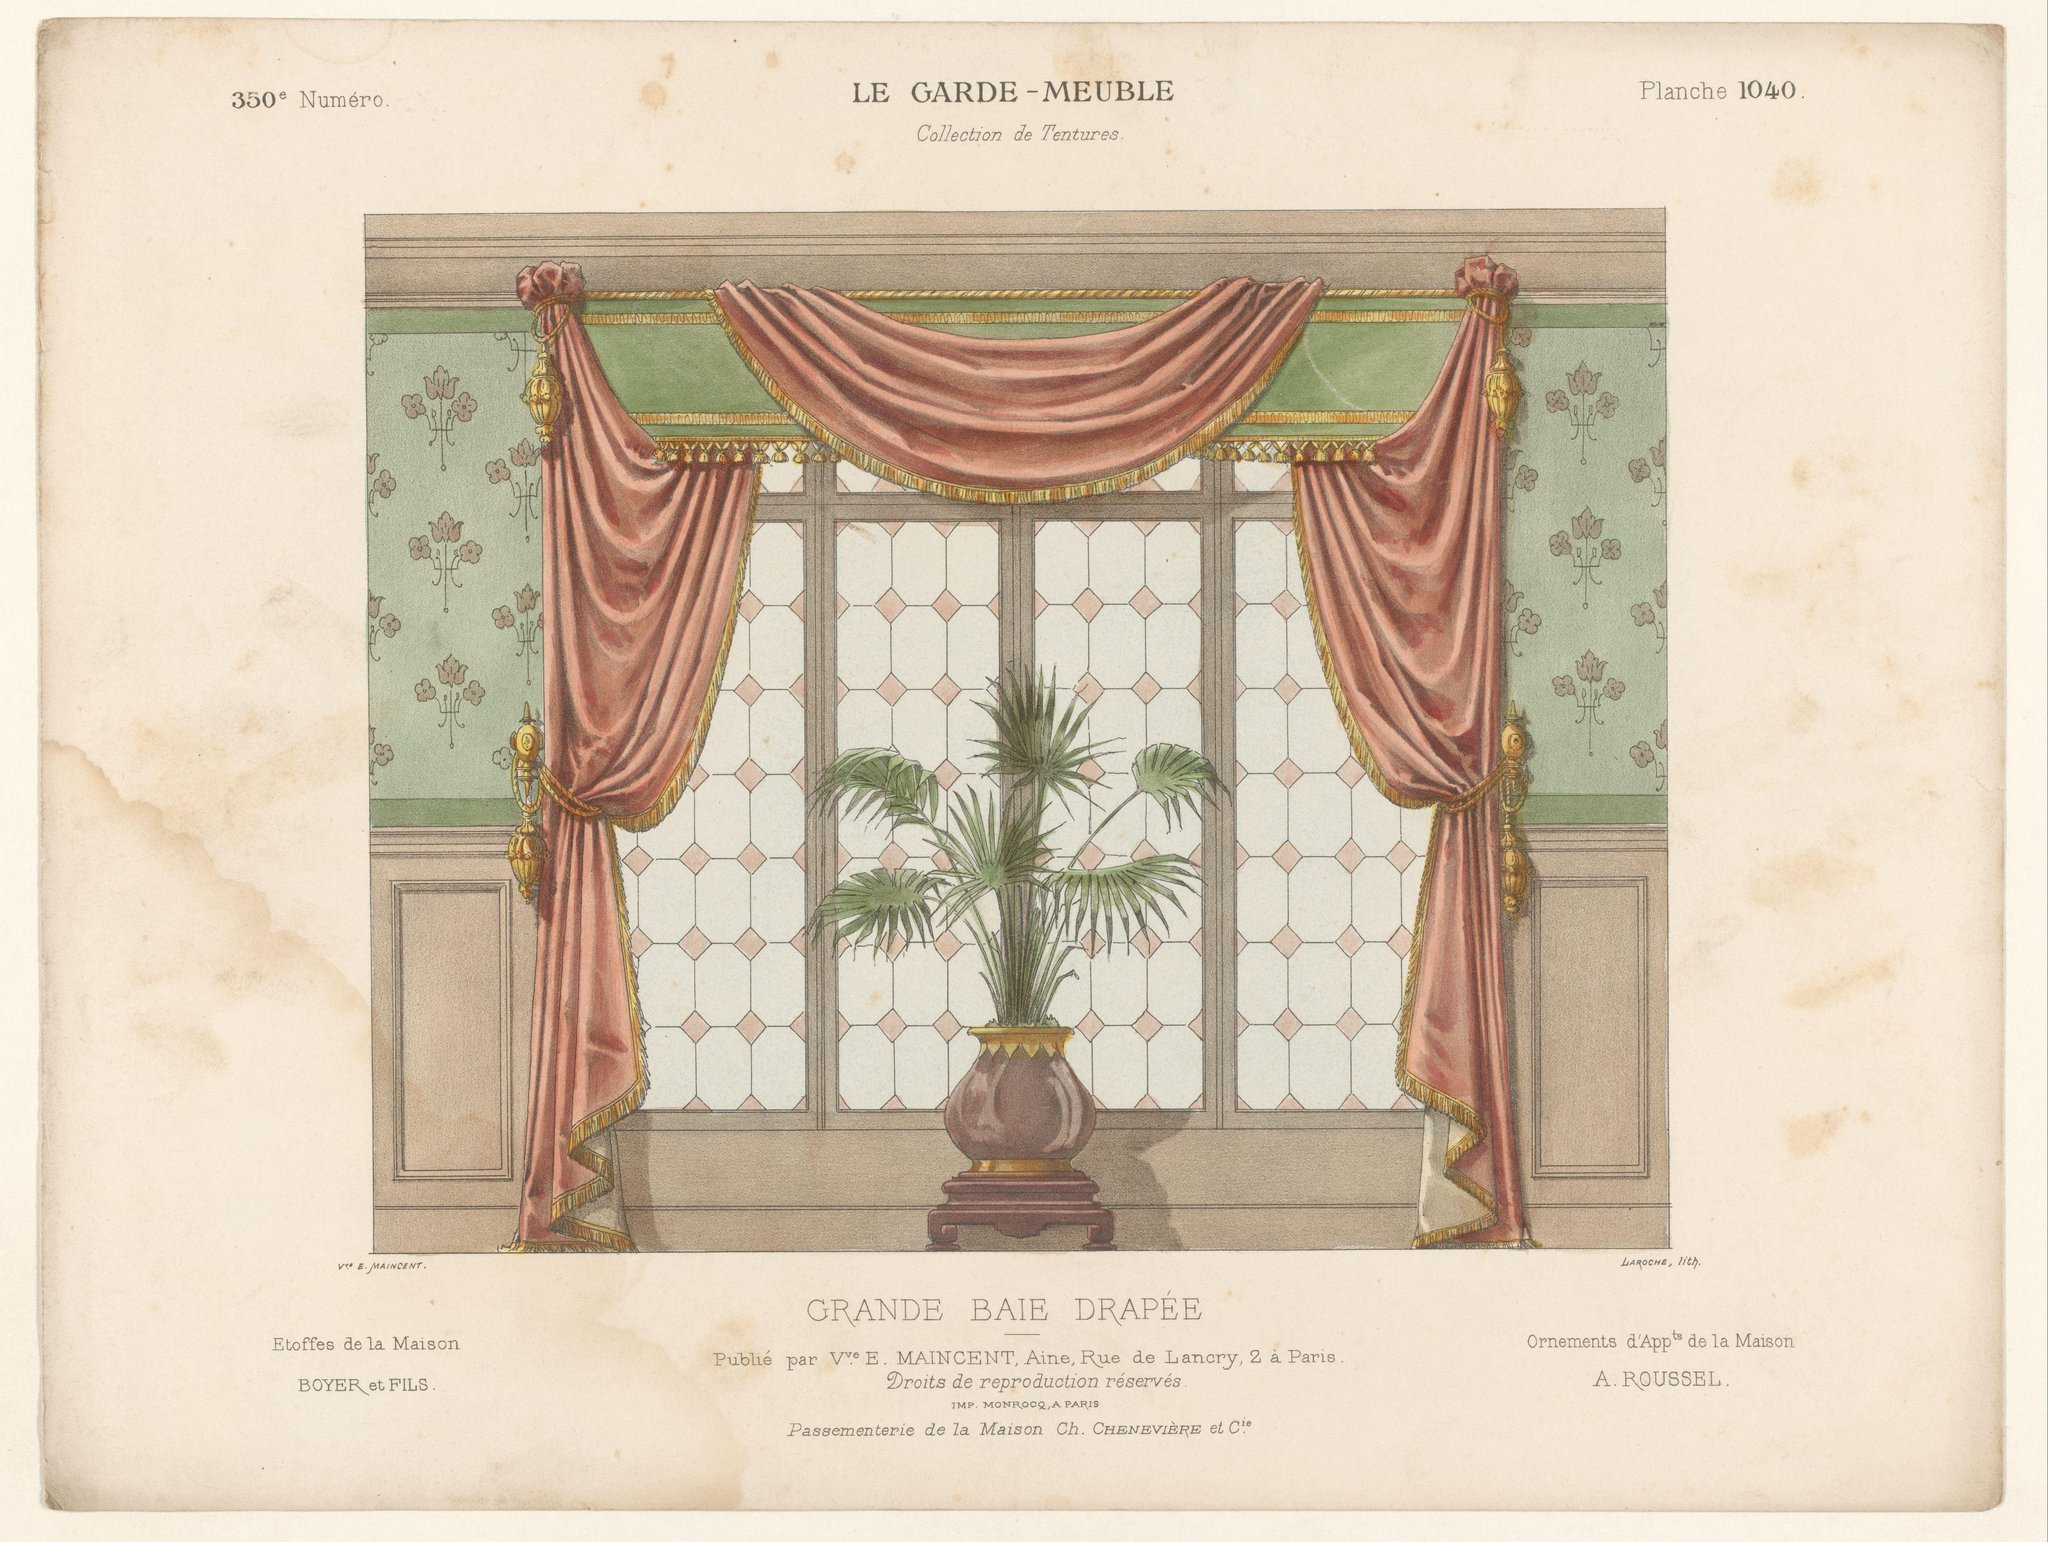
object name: print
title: Raampartij met gordijnen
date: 1890-1910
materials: paper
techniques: hand coloring, lithograph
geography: paris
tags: window, hangings and drapery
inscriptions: : ‘Droits de reproduction réservés.’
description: Grote raampartij met kamerplant en gedrapeerde gordijnen. Prent uit 350e Livraison.